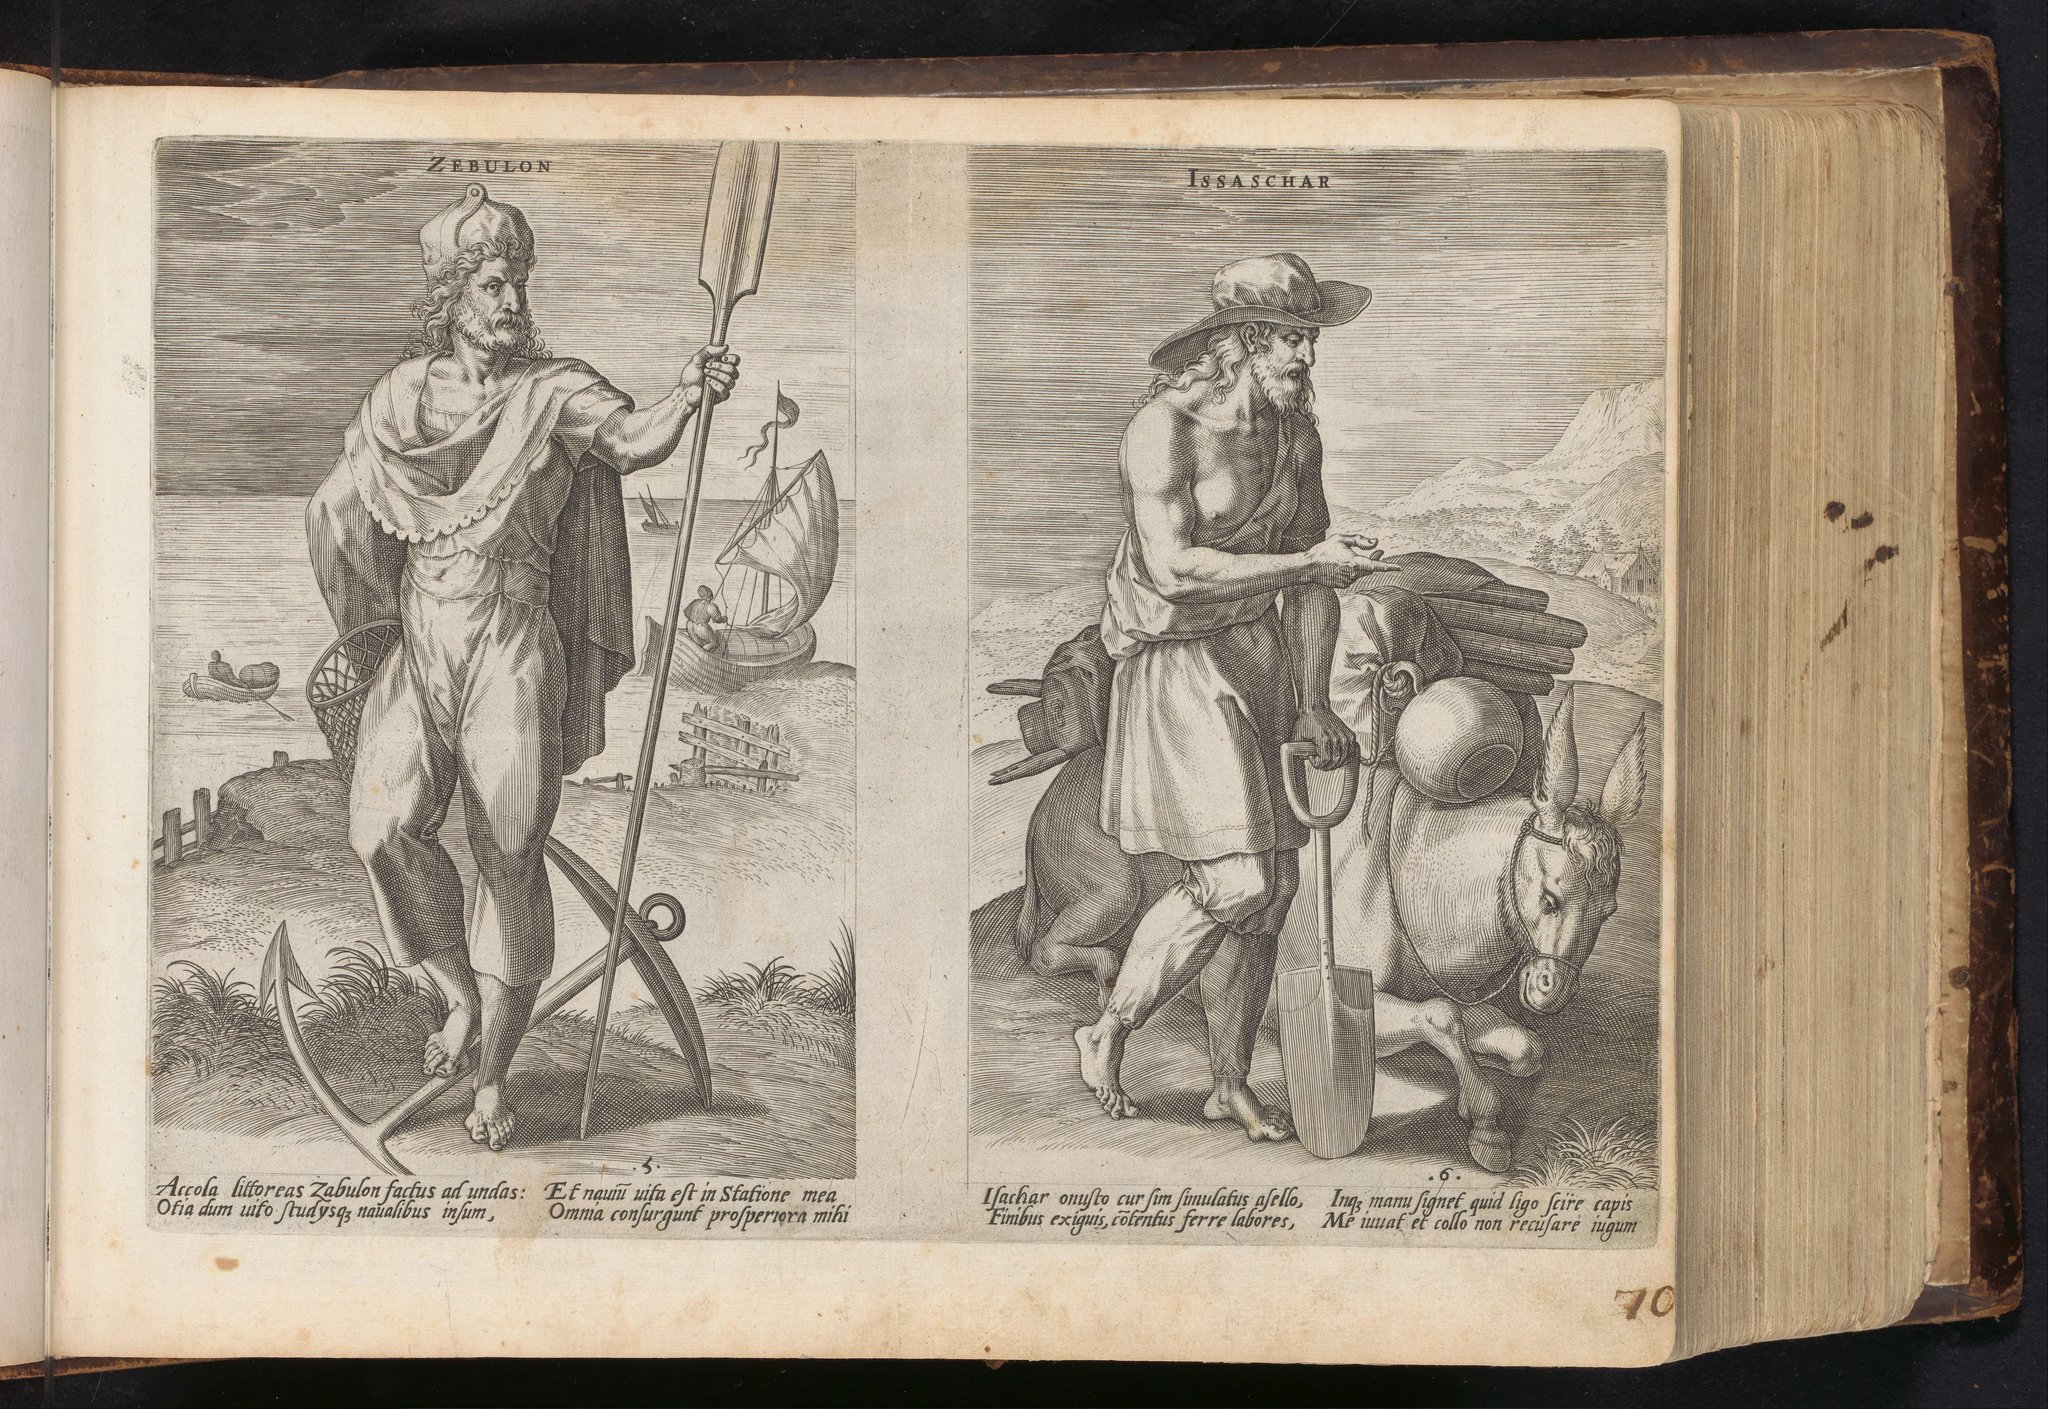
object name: print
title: De twaalf stamvaders van Israël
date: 1585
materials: paper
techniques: engraving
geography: amsterdam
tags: 11i611(issaschar), 11i611(zebulon)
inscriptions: number: ‘70’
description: Links stamvader Zebulon, de tiende zoon van Jakob. Hij is gekleed als visser. Op de grond naast hem een anker. Op de achtergrond de zee en een strand, een verwijzing naar de woonplaats van Zebulon. Rechts stamvader Issachar, de negende zoon van Jakob. Naast hem ligt een ezel, een verwijzingen naar Issachar als een 'sterke ezel'. Onder de voorstellingen een verwijzing in het Latijn naar de Bijbeltekst. Deze prent maakt deel uit van een album.